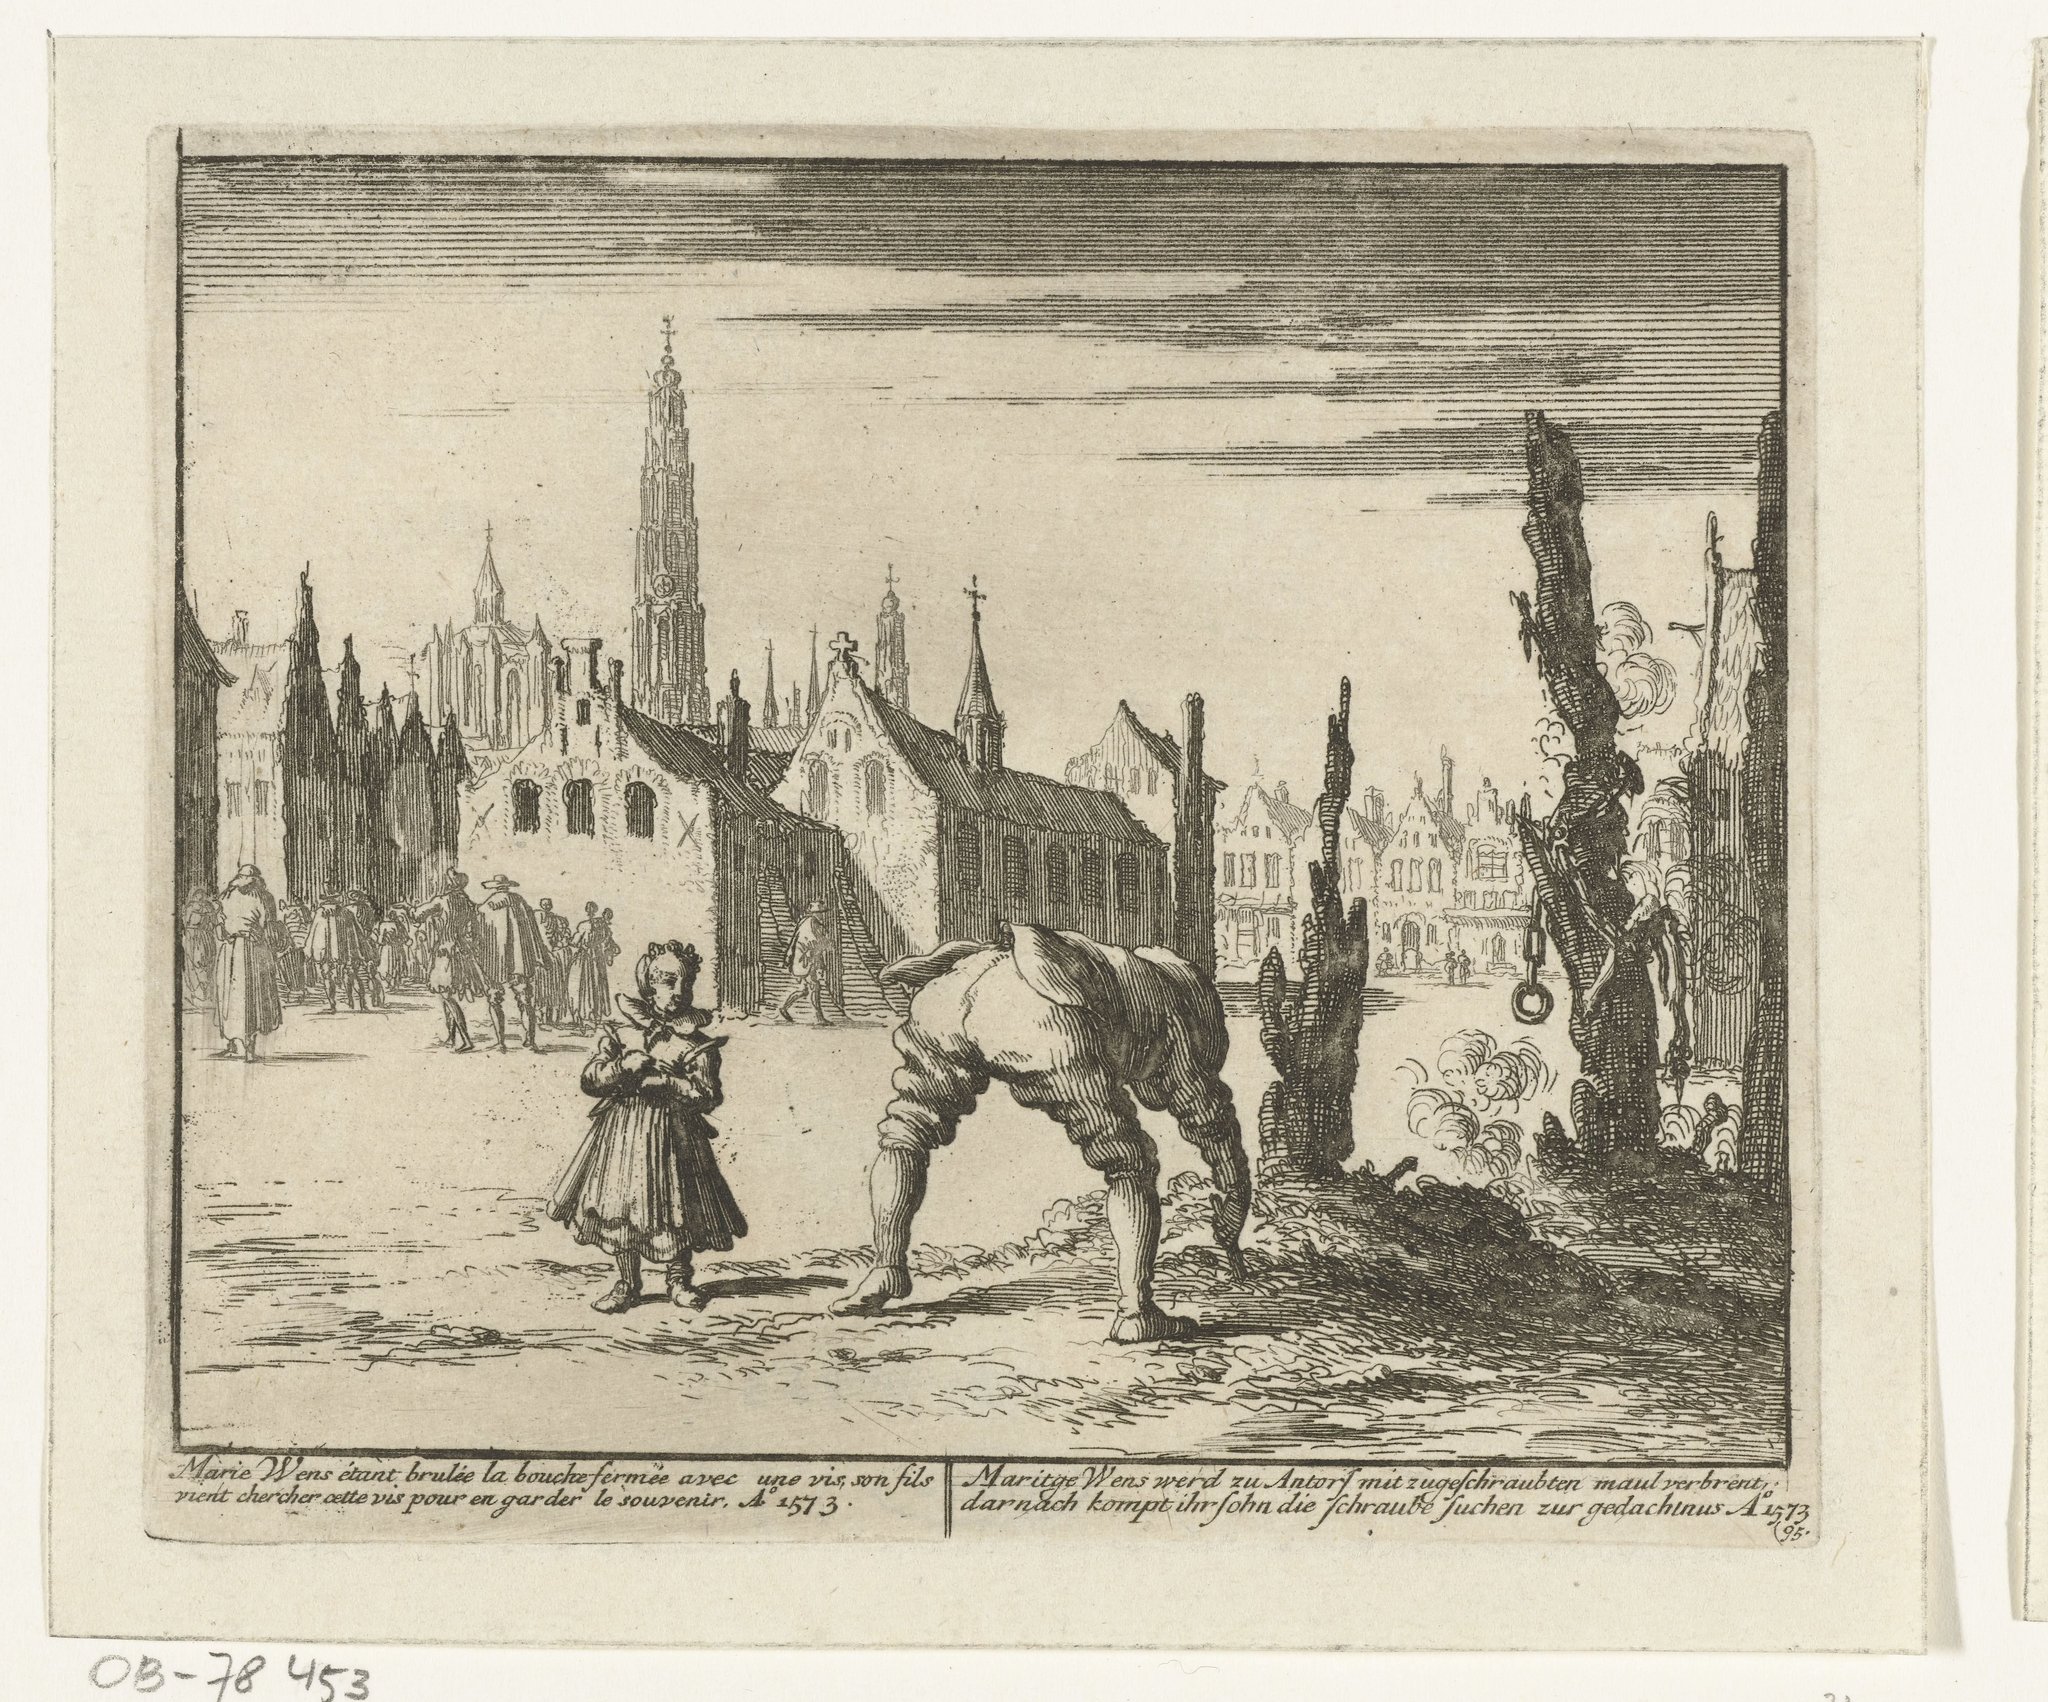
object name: print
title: Marie Wens étant brulée la bouche fermée avec un vis, son fils vient chercher cette vis pour en garder le souvenir, Ao. 1573 / Maritge Wens werd zu Antorf mit zugeschraubten maul verbrent darnach kompt ihr sohn die schraube suchen zur gedachtnus, Ao. 1573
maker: jan luyken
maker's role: draughtsman, print maker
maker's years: 1649-1712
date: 1683-1685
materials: paper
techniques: etching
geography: northern netherlands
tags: antwerp, violent death by burning at the stake; pyre, persecution of heretics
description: De prenten in deze tweede staat gebruikt als illustratie voor: Theatre des martyrs, depuis la mort de J. Christ jusqu'à present (...). = Schau-buhne der Martyrer, P. van der Aa, Leiden ca. 1715, nr. 95. De prenten zijn oorspronkelijk vervaardigd voor en eerst gebruikt in: T.J. van Bragt, Het bloedig tooneel, of Martelaers spiegel der doops-gesinde of weereloose christenen, 1685.